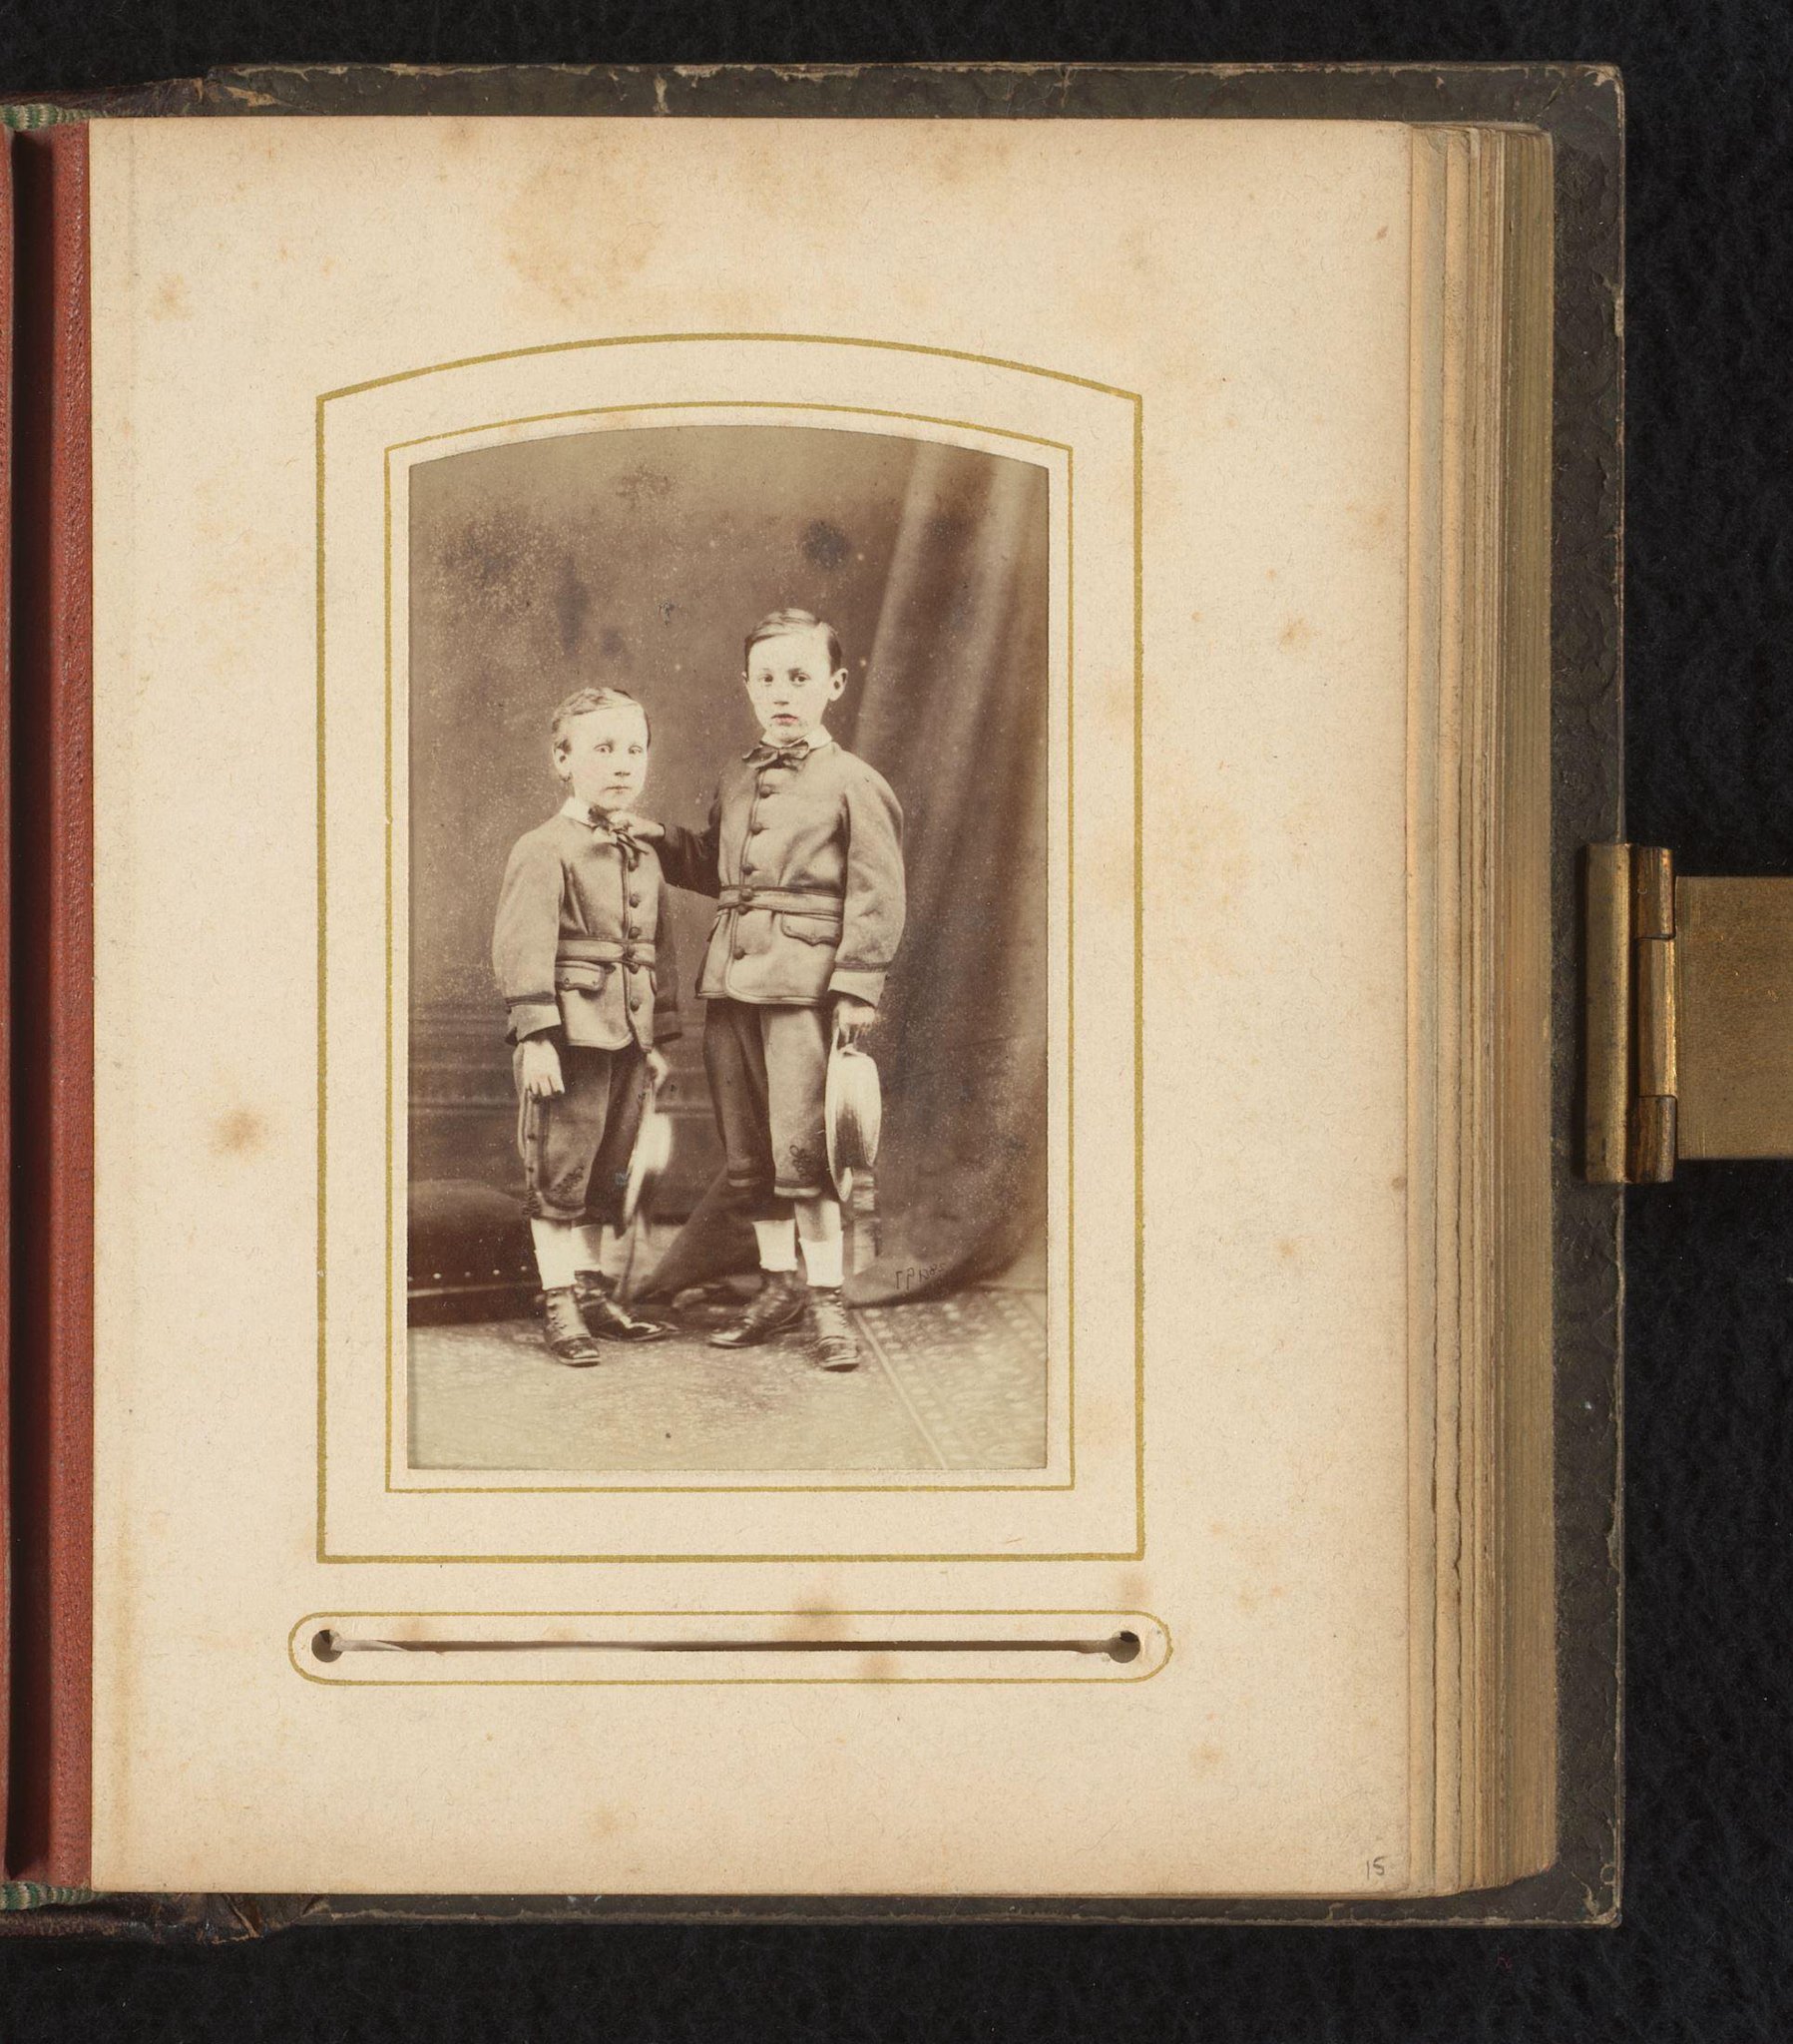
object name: photograph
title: Portret van twee jongens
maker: elias gottheil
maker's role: fotograaf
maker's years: 1820-1899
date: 1863-1883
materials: cardboard, photographic support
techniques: albumen print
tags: boy (child between toddler and youth), historical persons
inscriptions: inscription: ‘E.G. Gottheil/ Photographer/ 120, Mile end Road/ (...)’, name: ‘Gottheil’